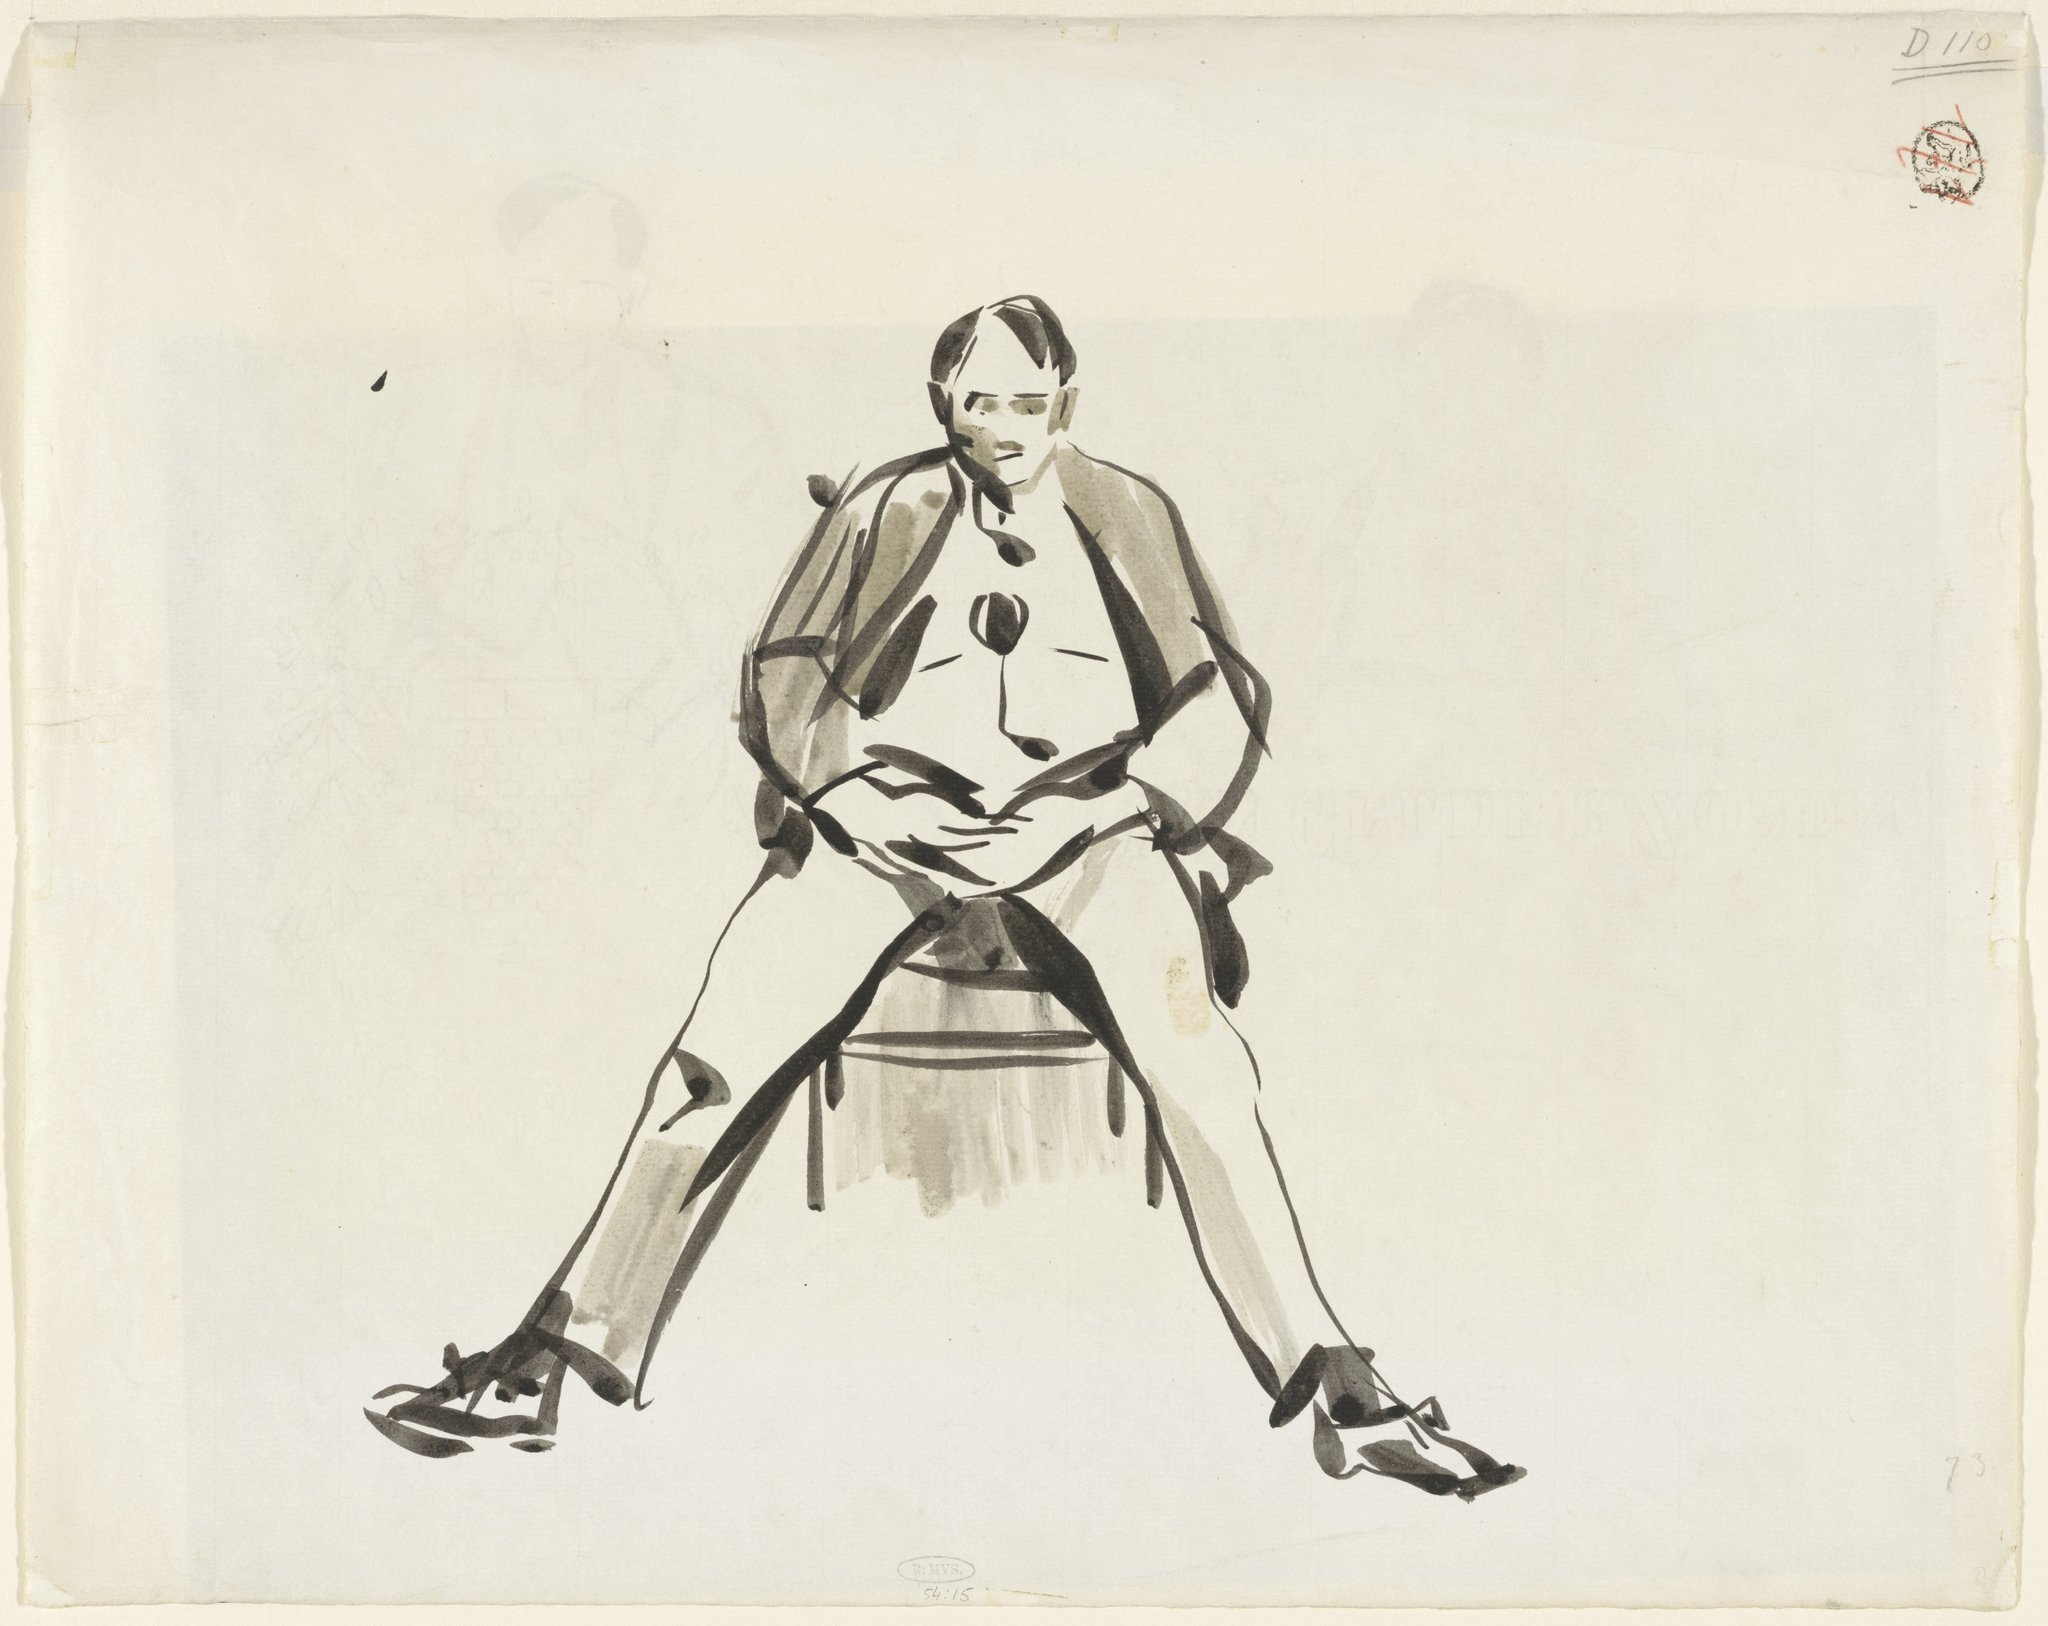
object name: drawing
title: Studie van een man, wijdbeens zittend, ten voeten uit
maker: rik wouters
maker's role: draughtsman, print maker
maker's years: 1882-1916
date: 1892-1916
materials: paper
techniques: brush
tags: sitting figure